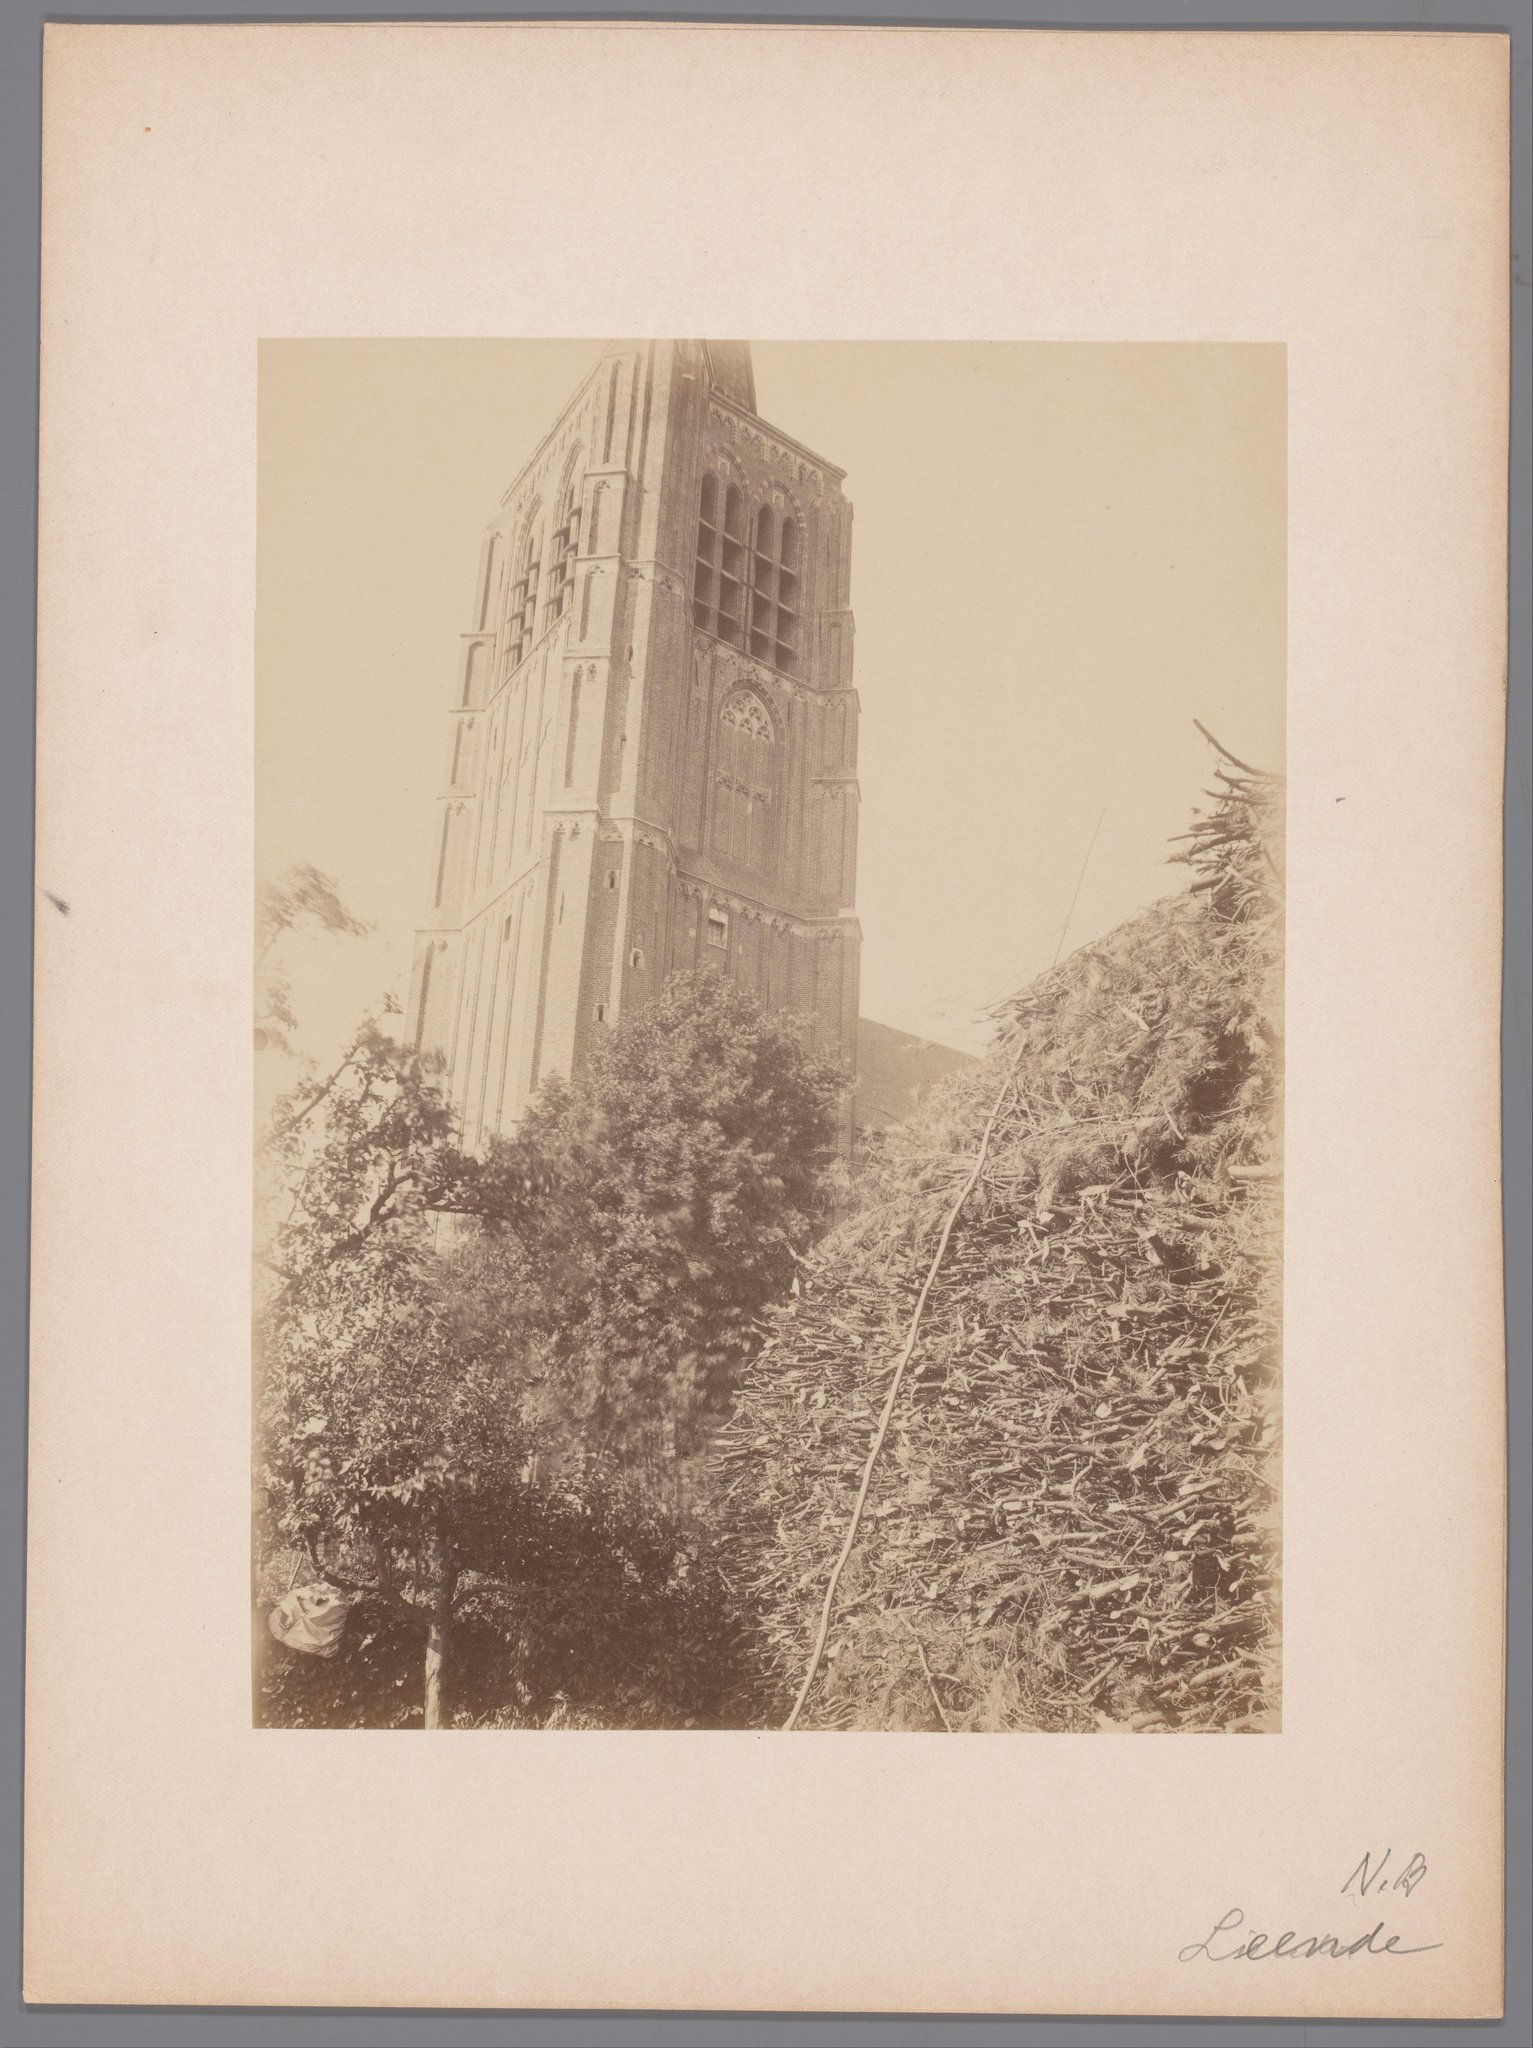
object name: photograph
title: Toren van de Sint-Petrus'-Bandenkerk te Leende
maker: anoniem (monumentenzorg)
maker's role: fotograaf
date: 1904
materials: cardboard, photographic support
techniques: albumen print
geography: leende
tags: parts of church exterior and annexes: tower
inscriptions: annotation: ‘Leende (N.B.)/ Toren v/d R.K. Kerk/ Juli 1904’, annotation: ‘N.Br. Leende’